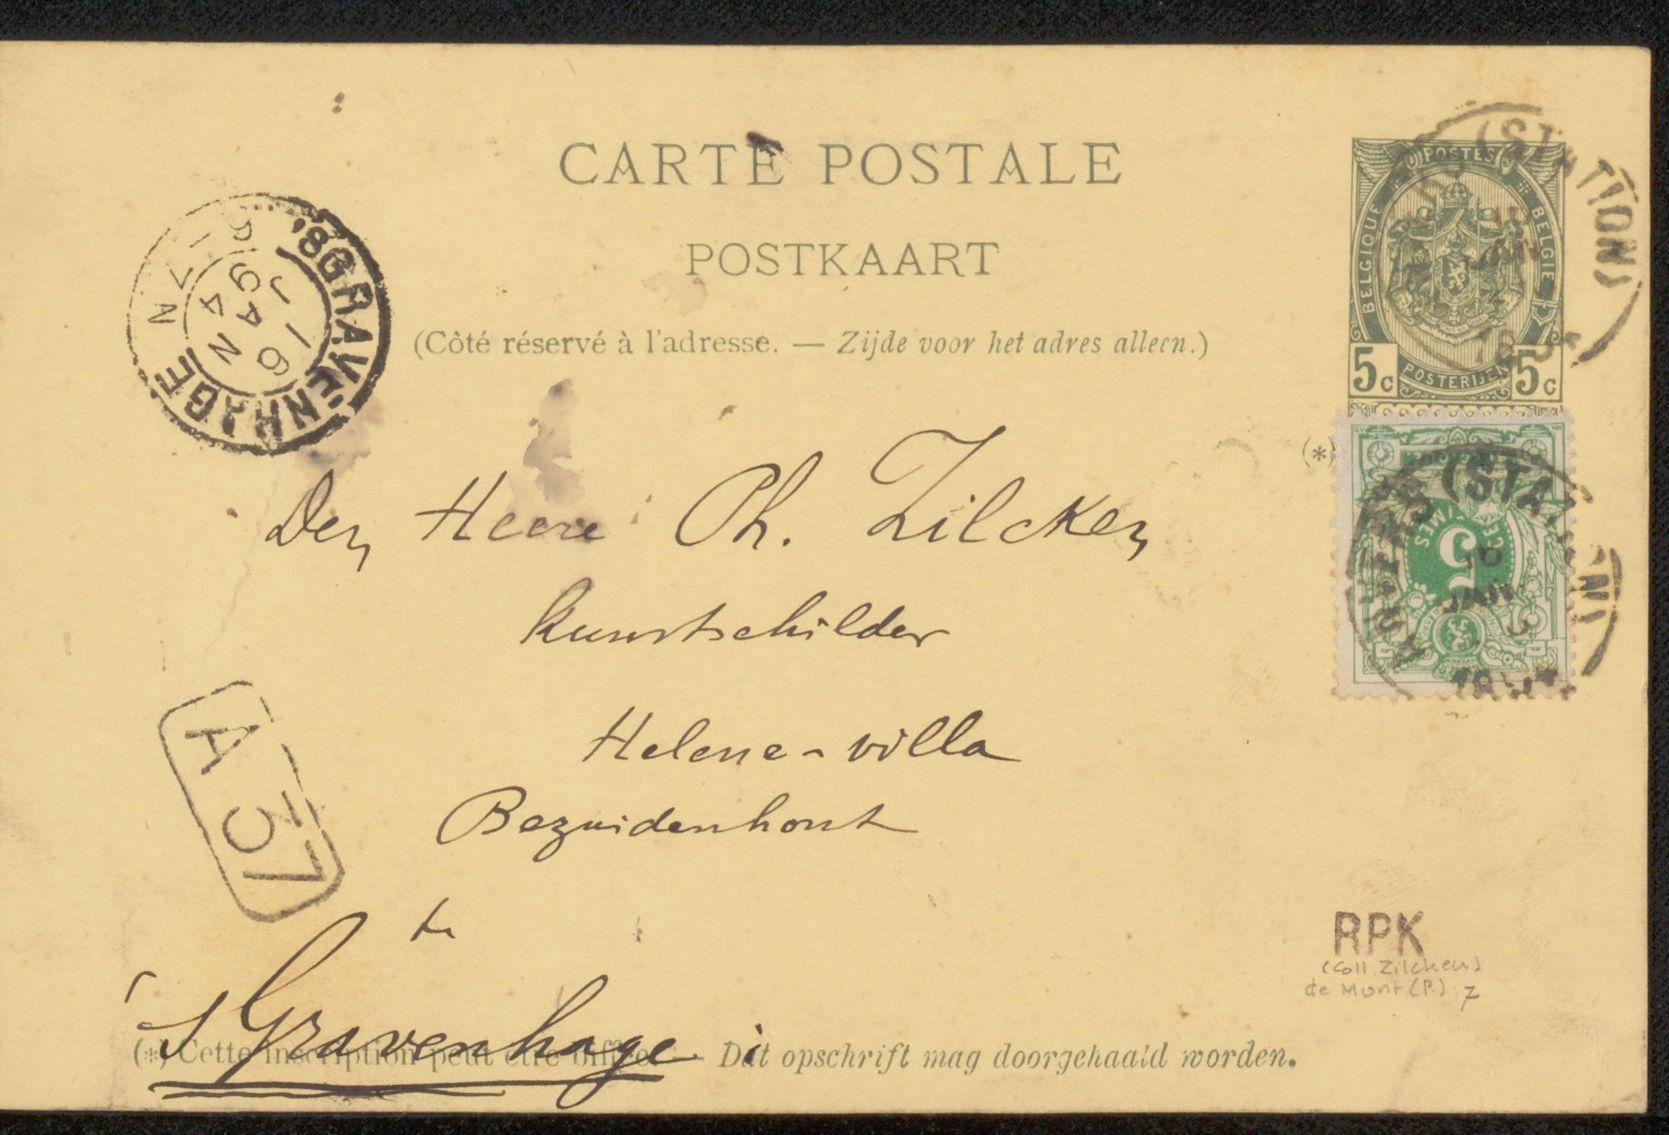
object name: postcard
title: Briefkaart aan Philip Zilcken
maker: pol de mont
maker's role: dichter, prozaschrijver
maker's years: 1857-1931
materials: cardboard, ink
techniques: pen, writing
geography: antwerp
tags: the hague, painter, philip zilcken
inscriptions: collector's mark: ‘RPK’